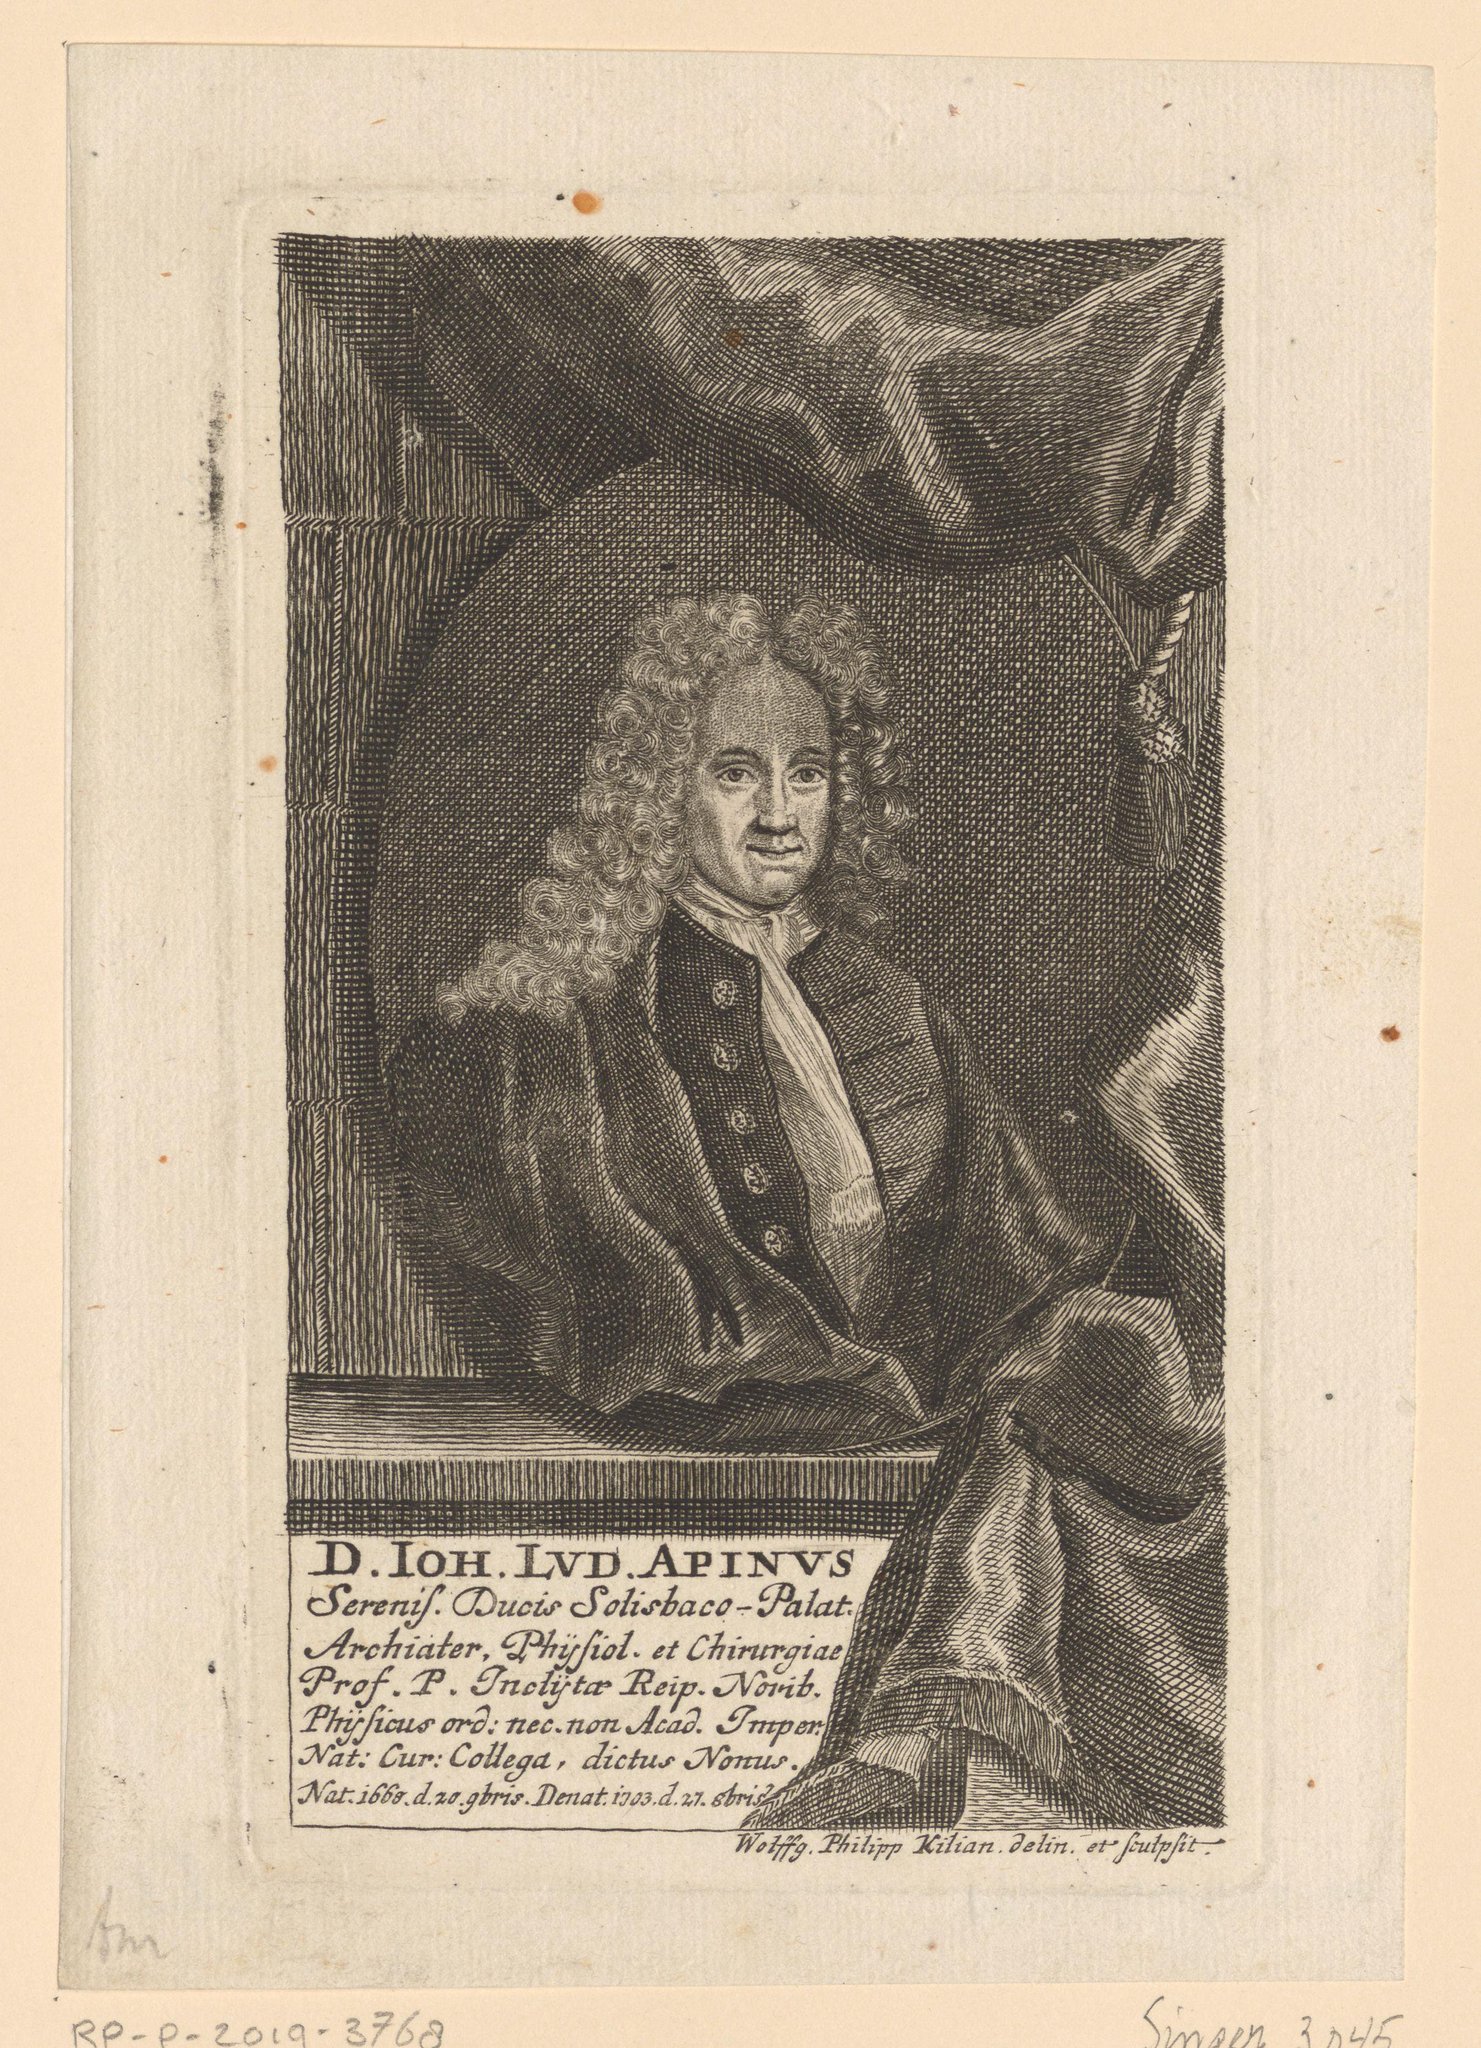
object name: book illustration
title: Portret van Johann Ludwig Apin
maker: wolfgang philipp kilian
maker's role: artist, draughtsman, print maker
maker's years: 1654-1732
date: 1728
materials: paper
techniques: engraving, etching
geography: nuremberg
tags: historical persons, physician, doctor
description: Prent uit: Baier, Johann Jacob. Biographiae professorum medicinae (...). Neurenberg: erven van Johann Daniel Tauber, 1728.